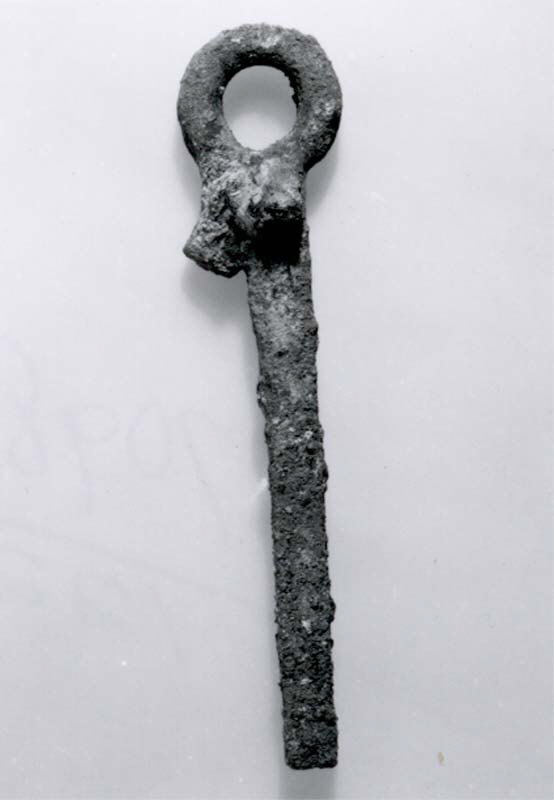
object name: bolt or linchpin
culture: iranian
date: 900-801 BCE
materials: bronze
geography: iran